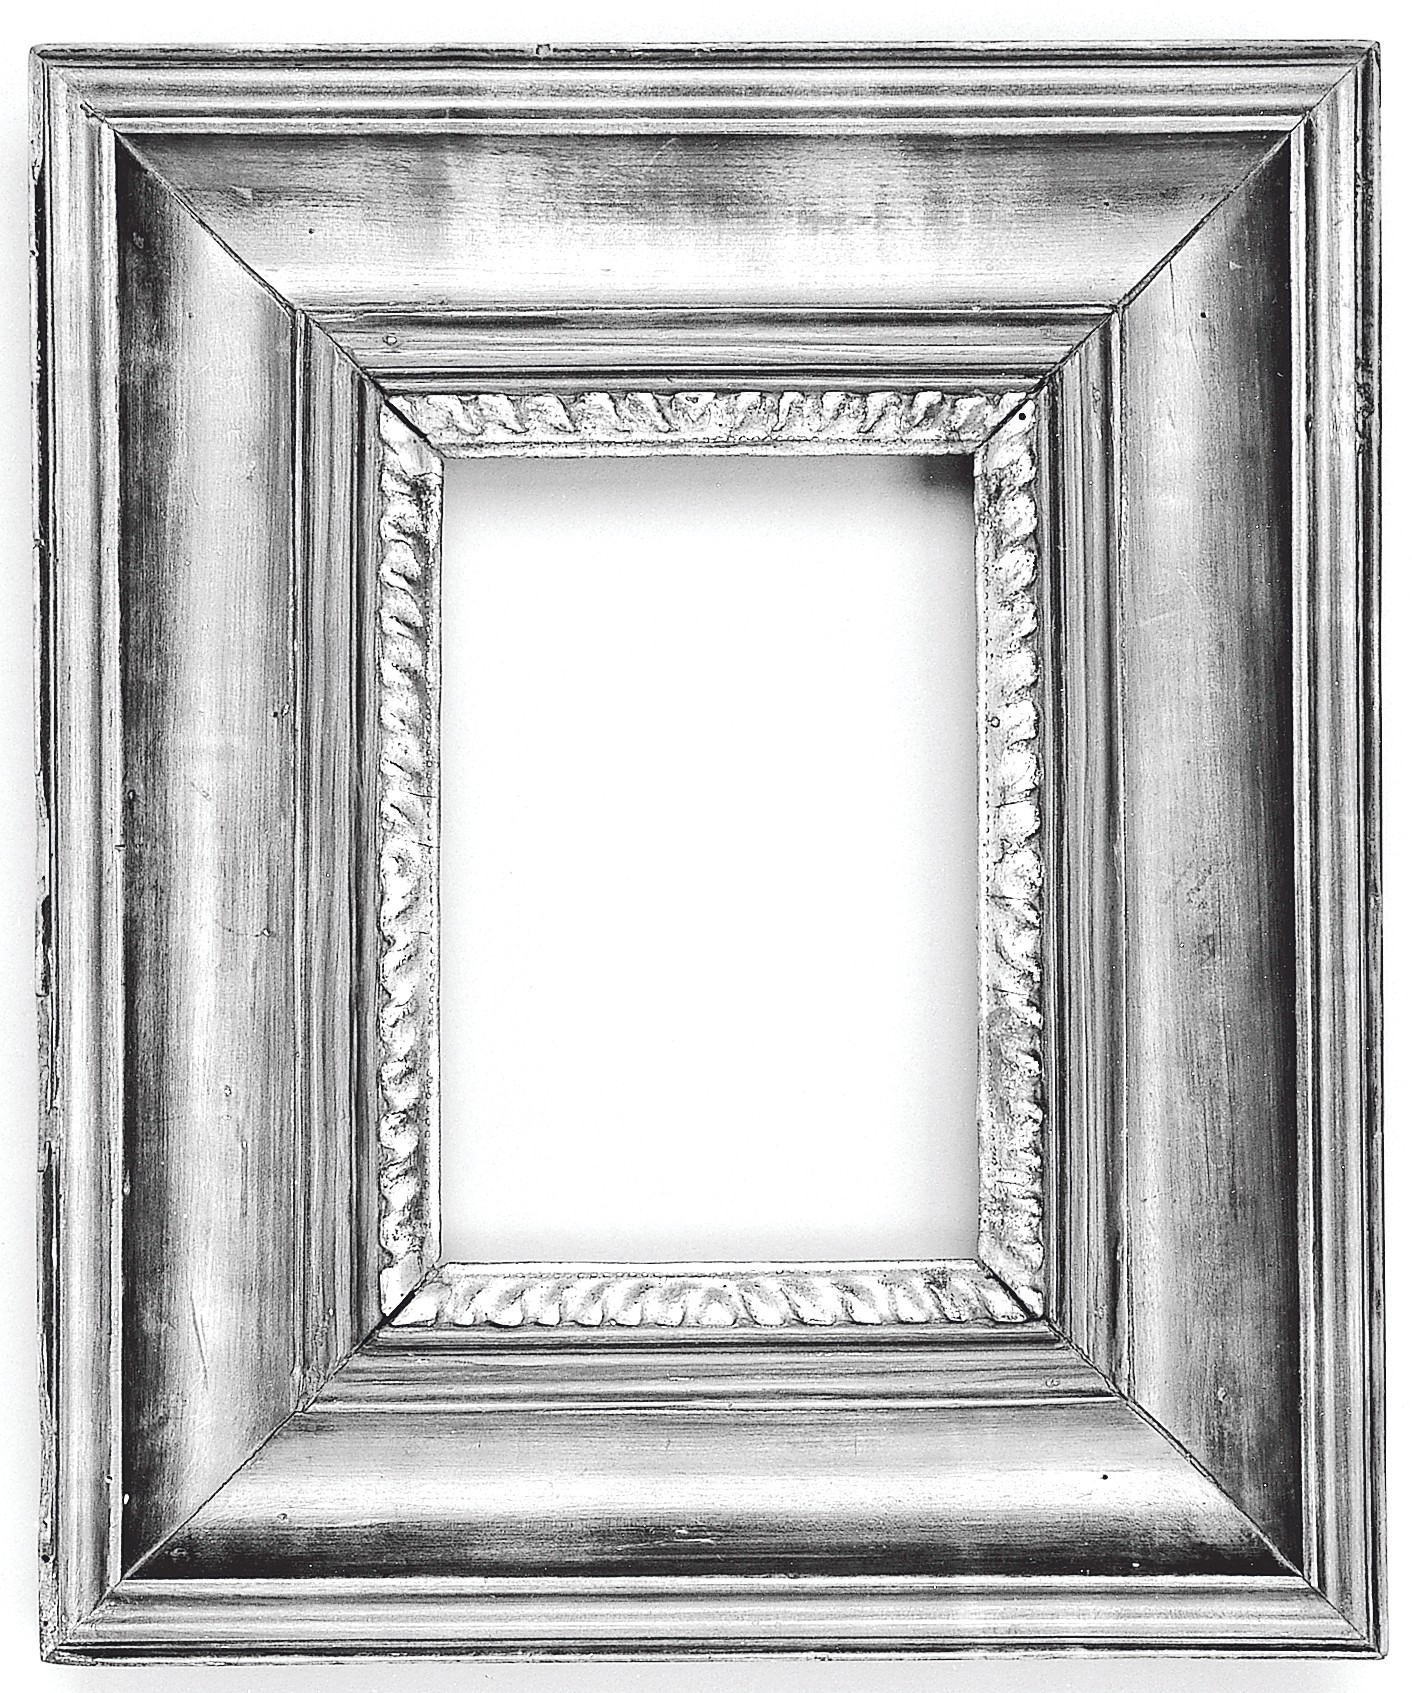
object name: frame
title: Hollow frame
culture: italian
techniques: polish